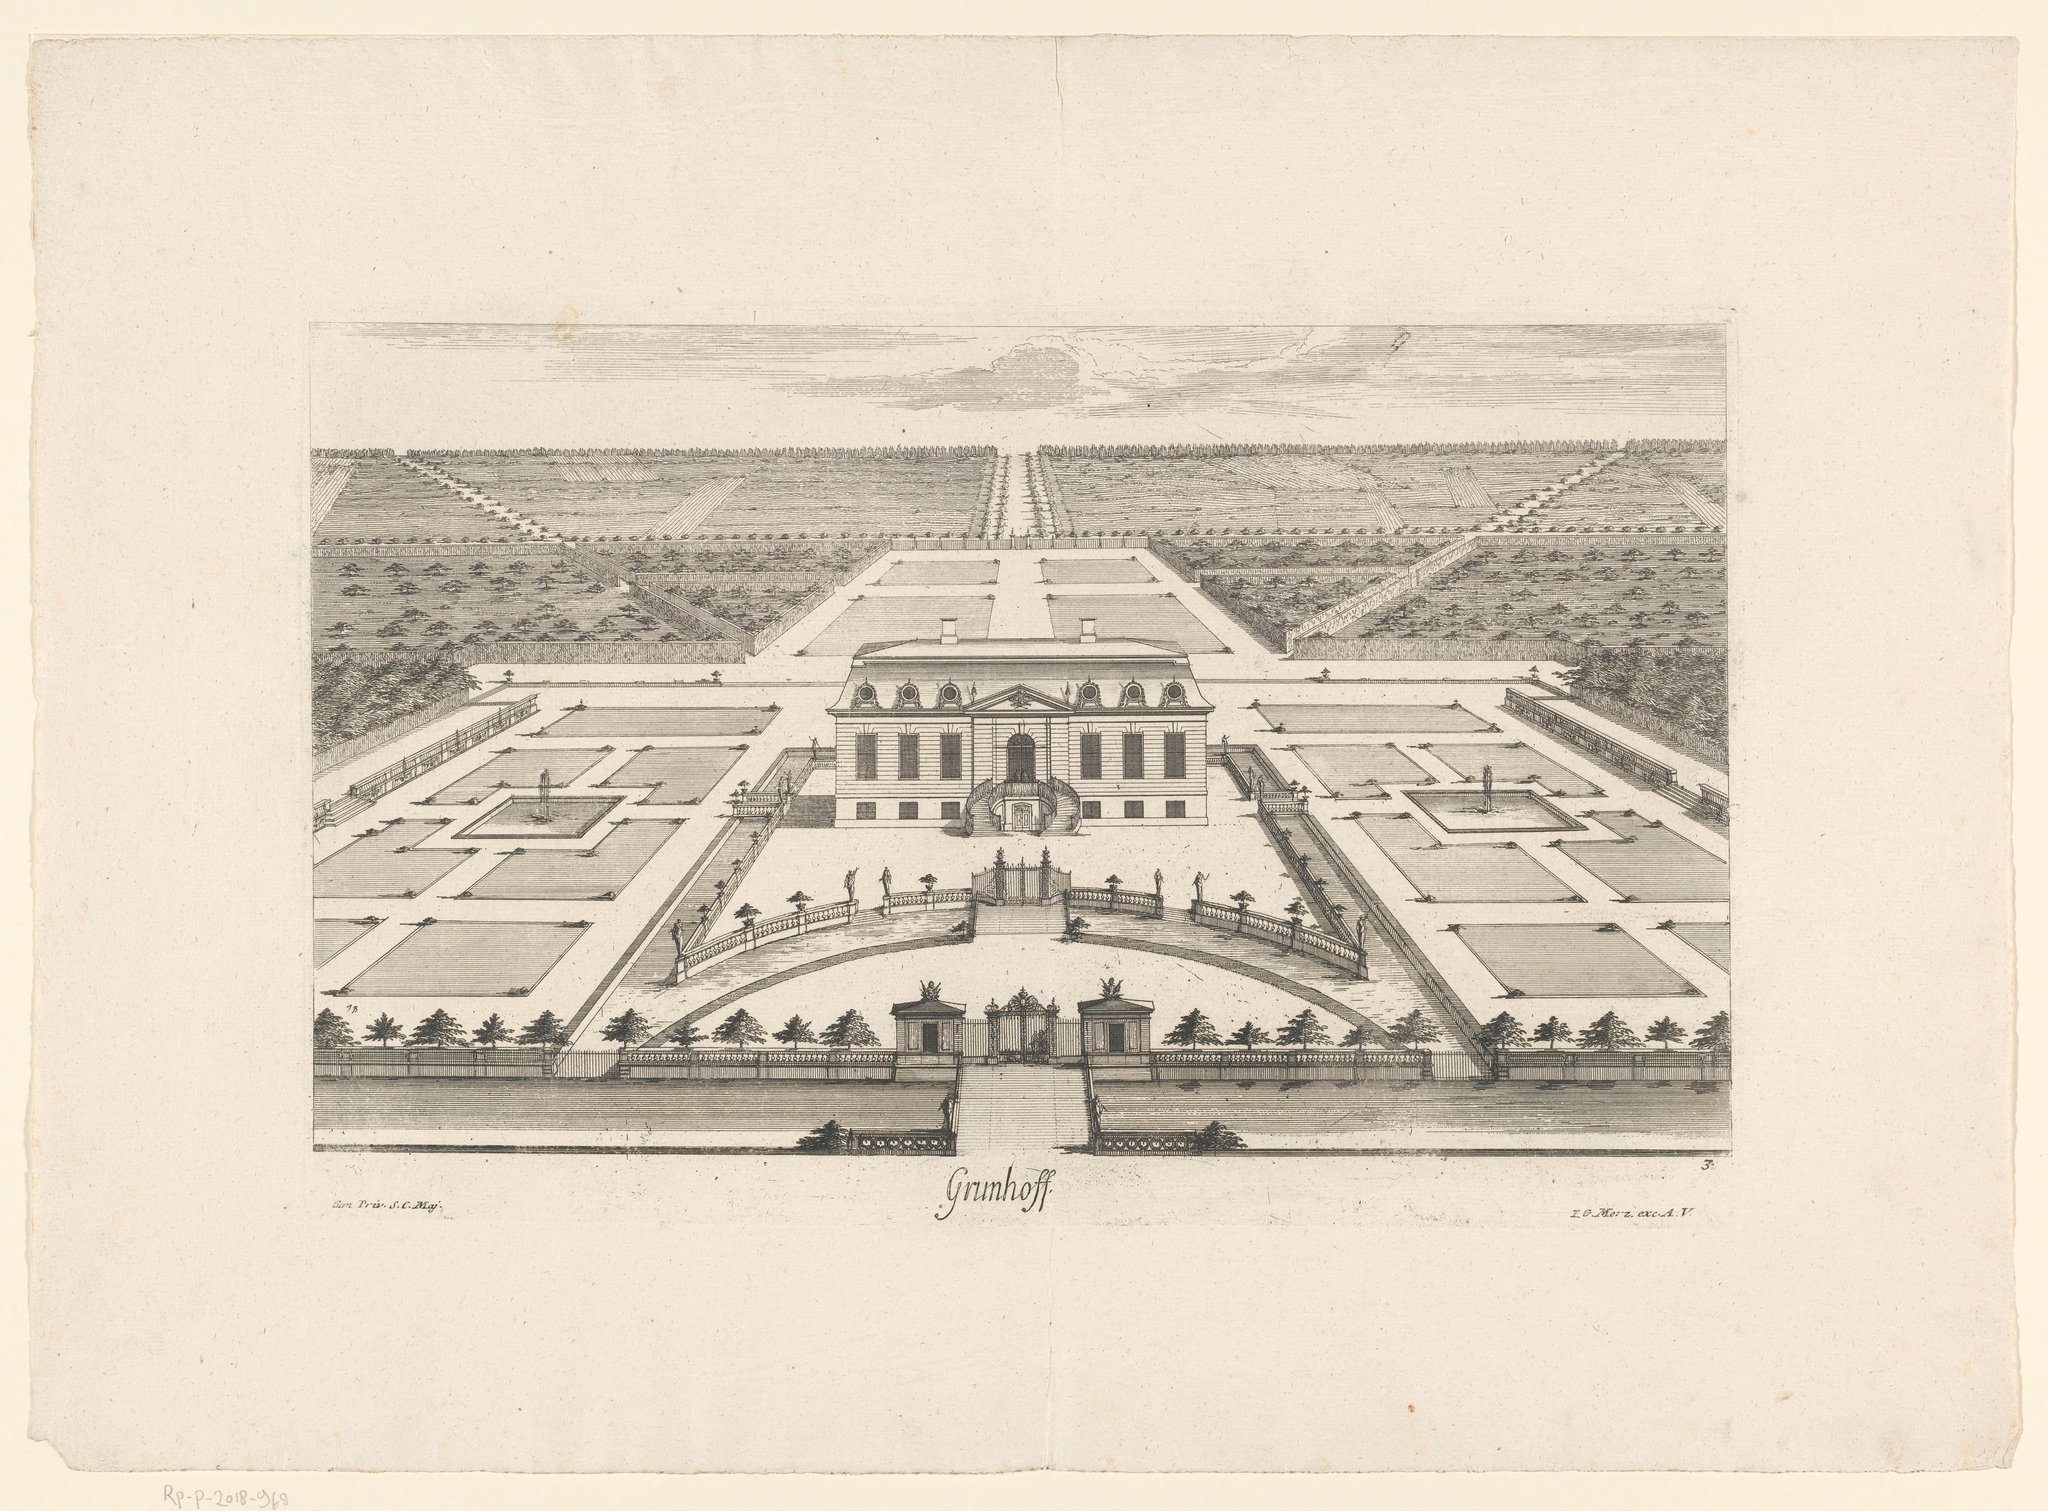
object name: print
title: Grunhof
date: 1733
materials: paper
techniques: etching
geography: augsburg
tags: palace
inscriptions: collector's mark: Lugt 2228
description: Prent gebruikt in: Broesbes, Jean-Baptiste. Vues des Palais et Maisons de Plaisance de Sa Majesté le Roy de Prusse. Augsburg: Johann Georg Merz, 1733.